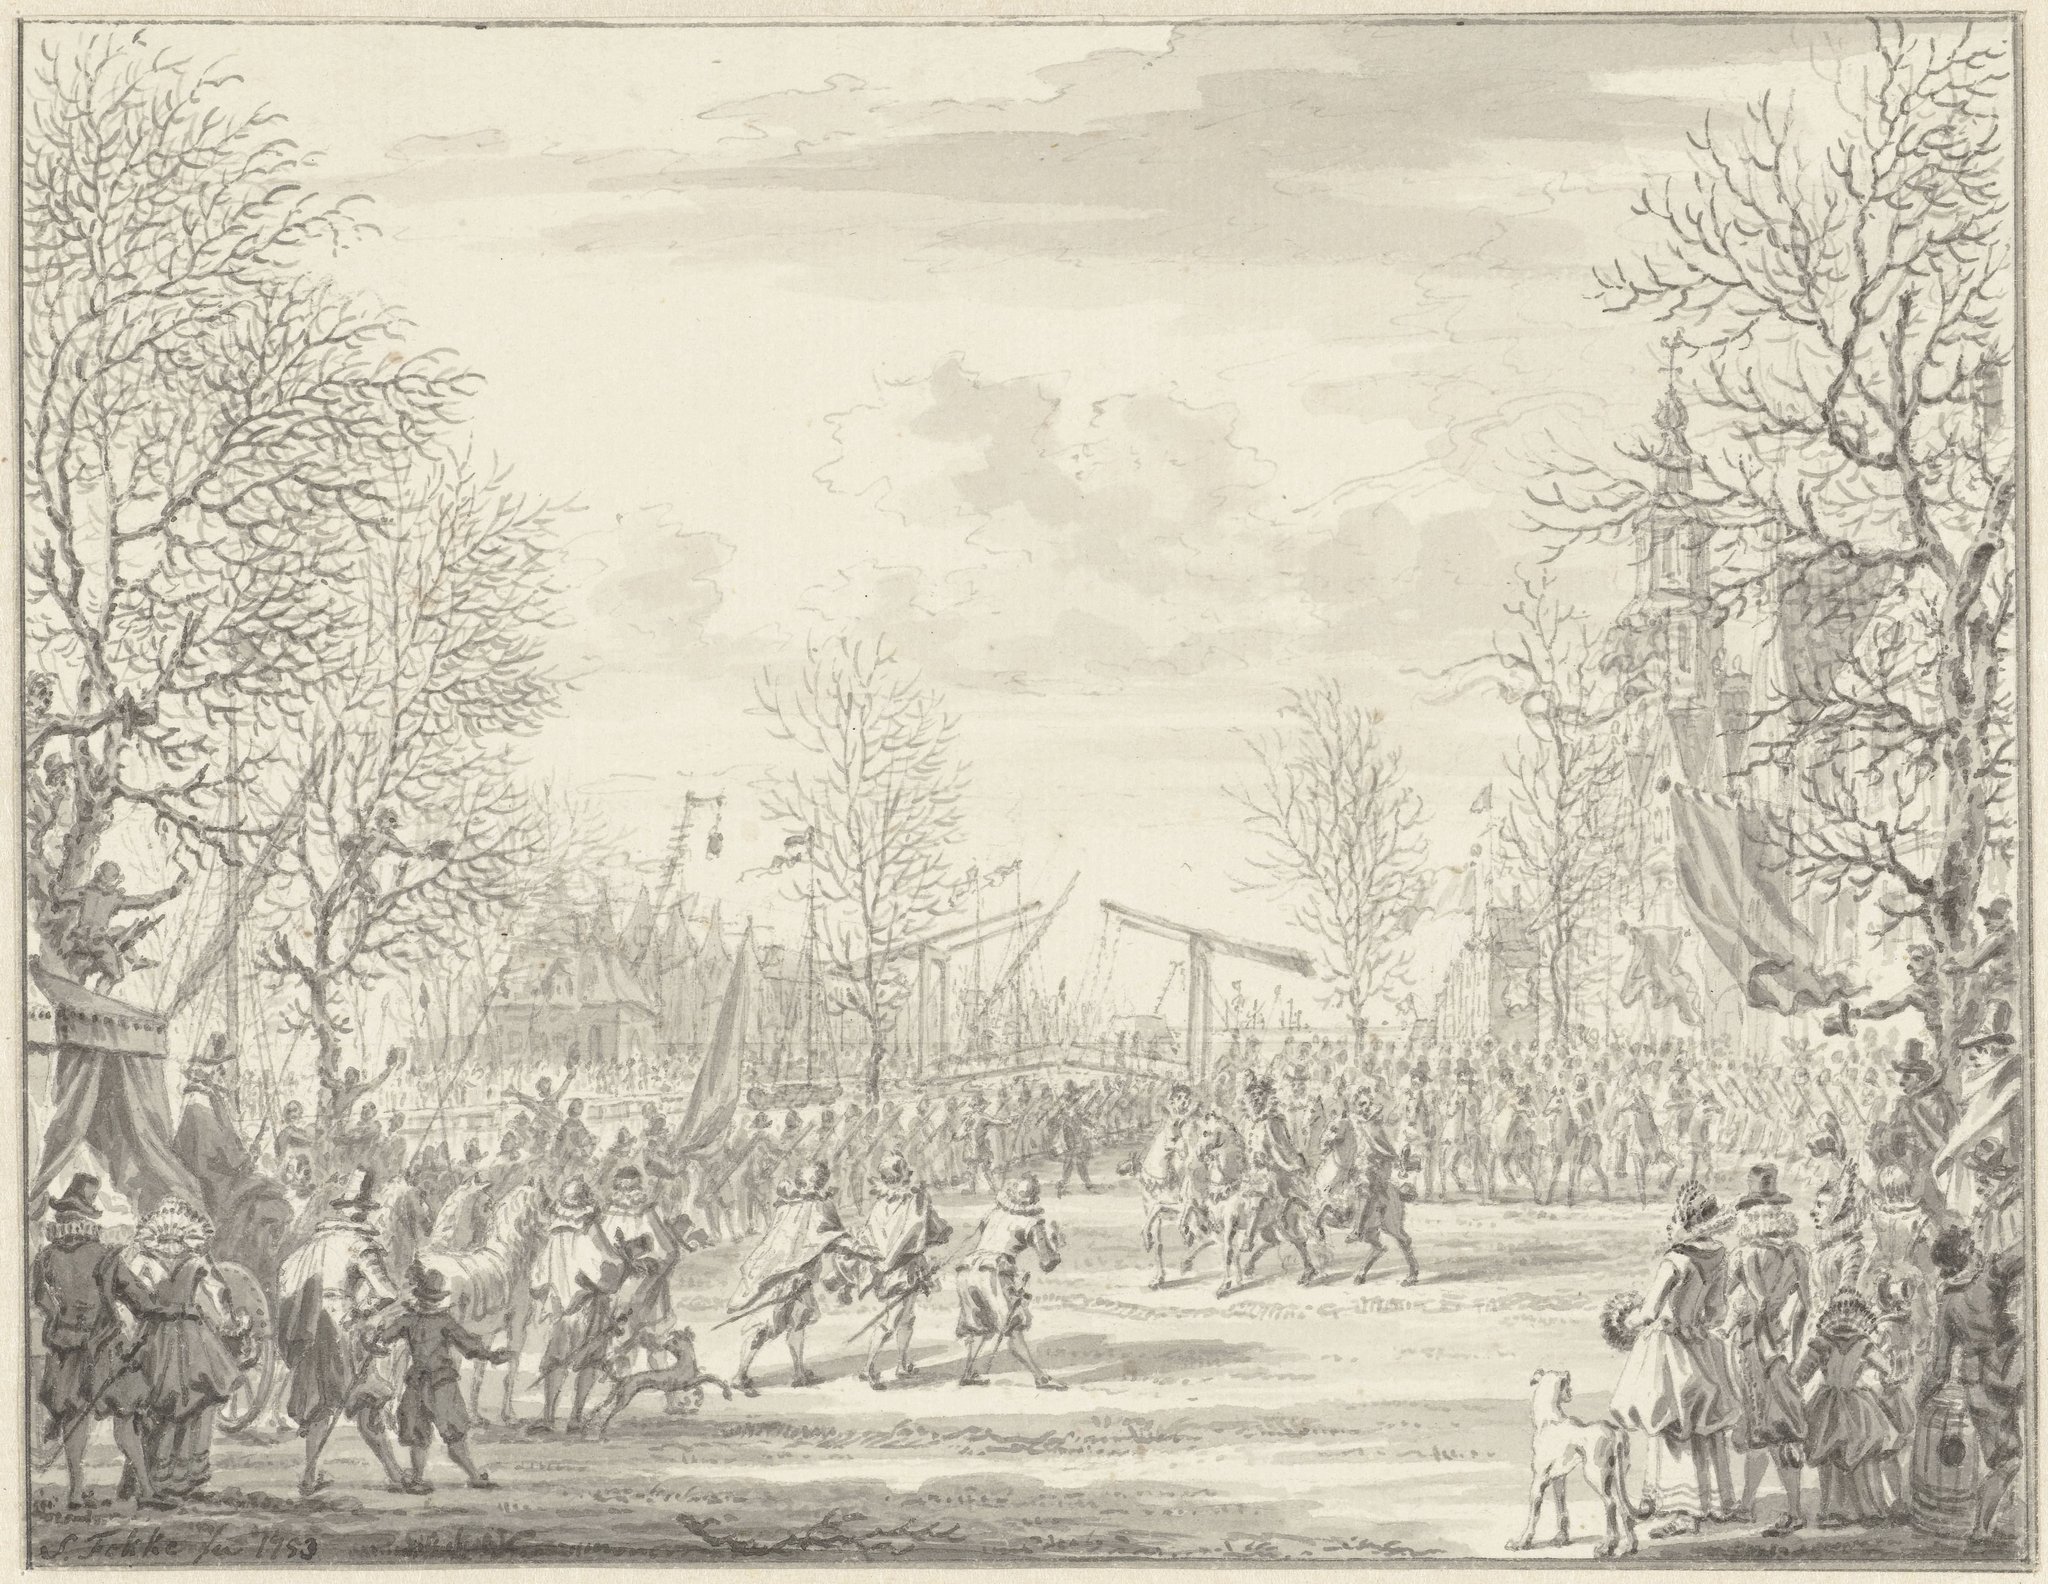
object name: drawing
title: Aankomst van Leicester te Vlissingen, 1585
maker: simon fokke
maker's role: draughtsman, print maker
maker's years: 1712-1784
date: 1753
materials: ink, paper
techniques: brush, pen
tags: robert dudley (1st earl of leicester), square, place, circus, etc., war and peace, bridge, flushing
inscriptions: date: ‘1753’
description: Aankomst van Robert Dudley, graaf van Leicester, in Vlissingen op 20 december 1585. Ontvangst van de graaf op de kade door een grote menigte. Ontwerp voor een prent.